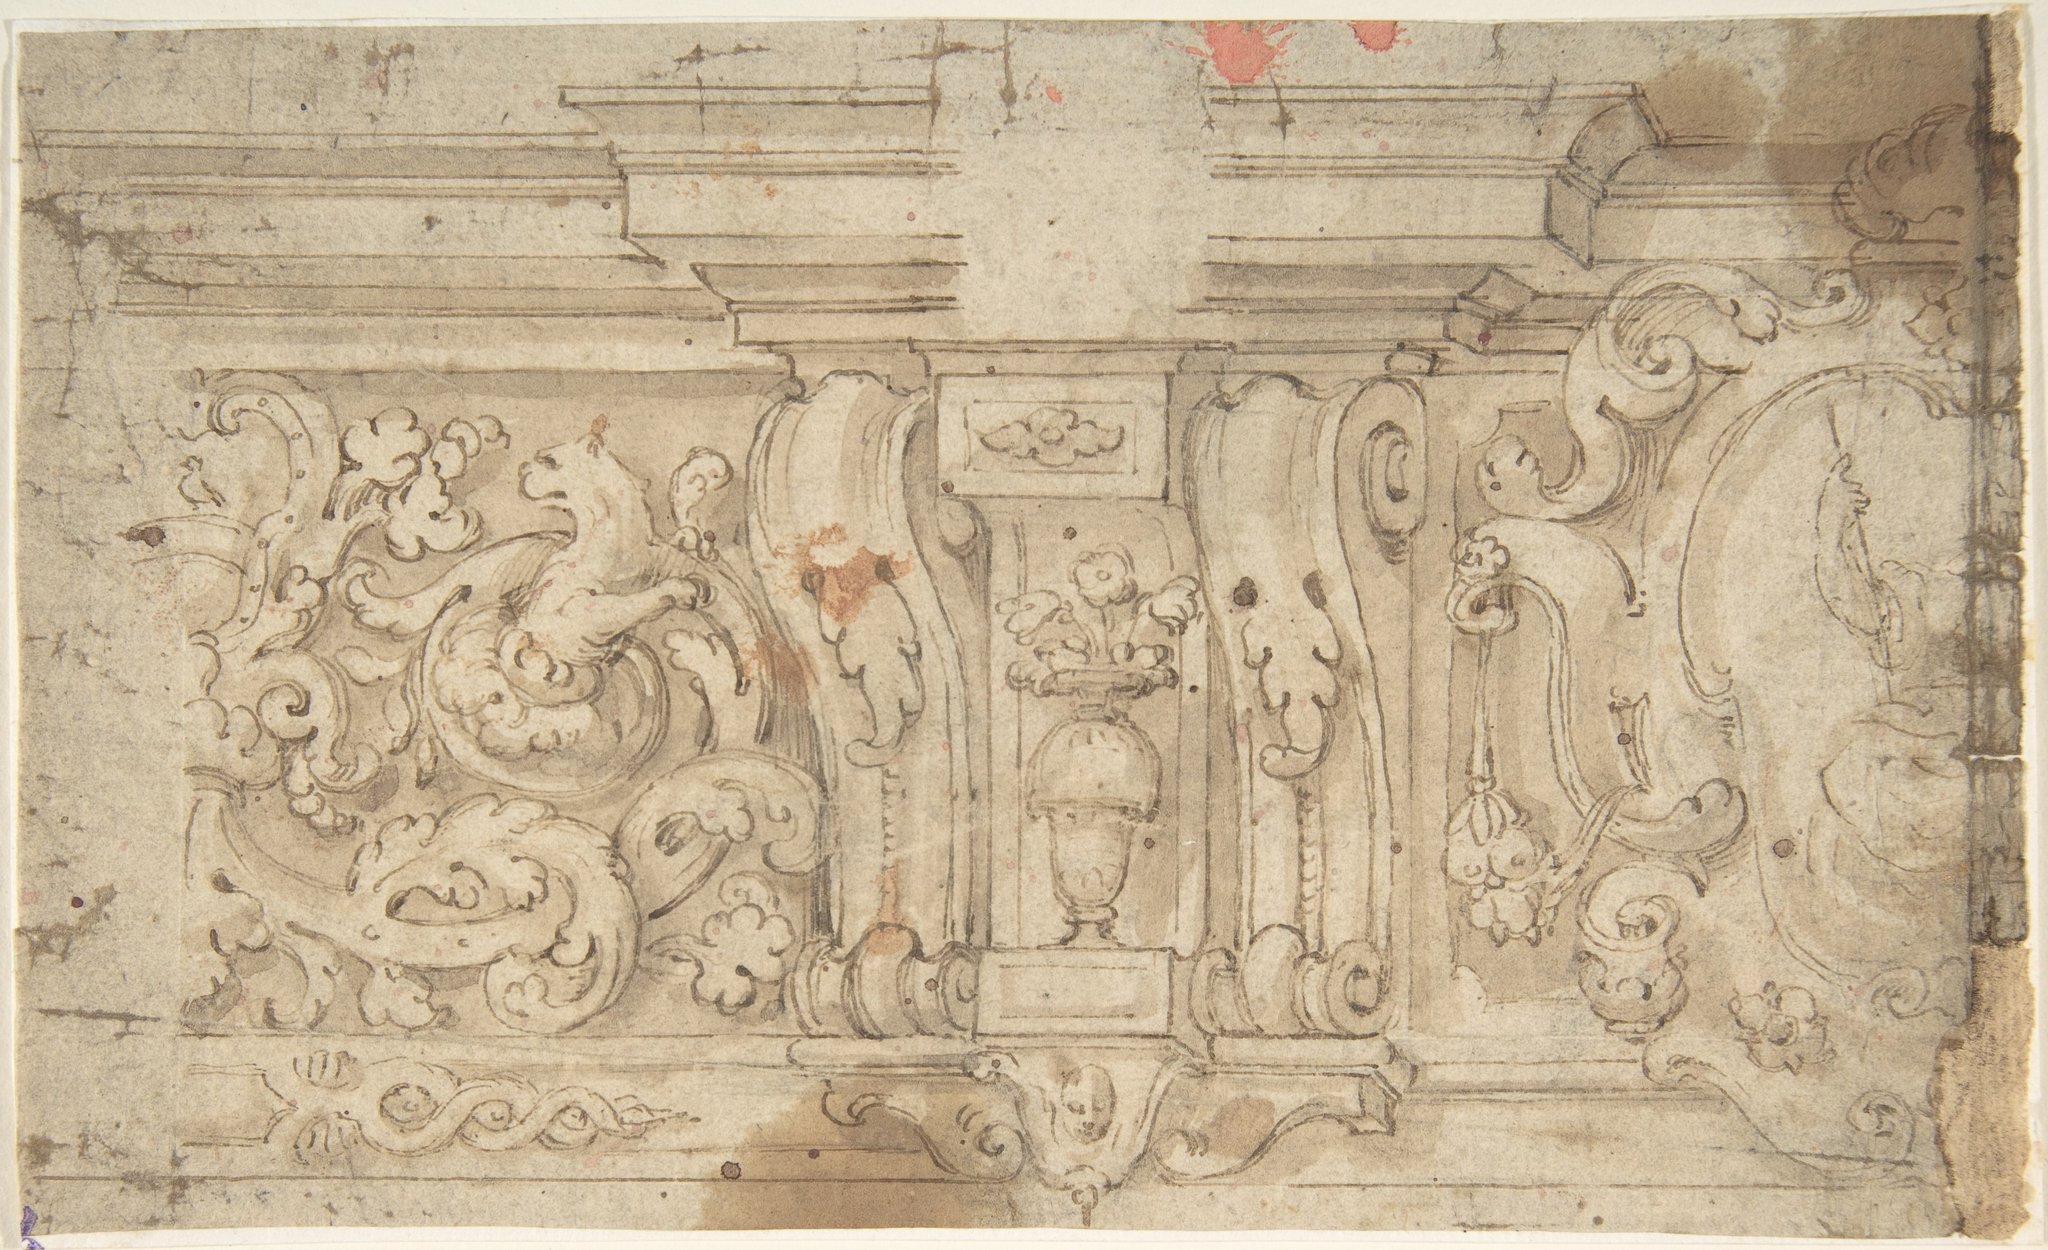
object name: drawing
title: Design for an Architectural Frieze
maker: anonymous, italian, mid-16th century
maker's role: artist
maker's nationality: italian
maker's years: 1520-1580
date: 1601-1700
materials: ink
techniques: brush, pen, wash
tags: ornament